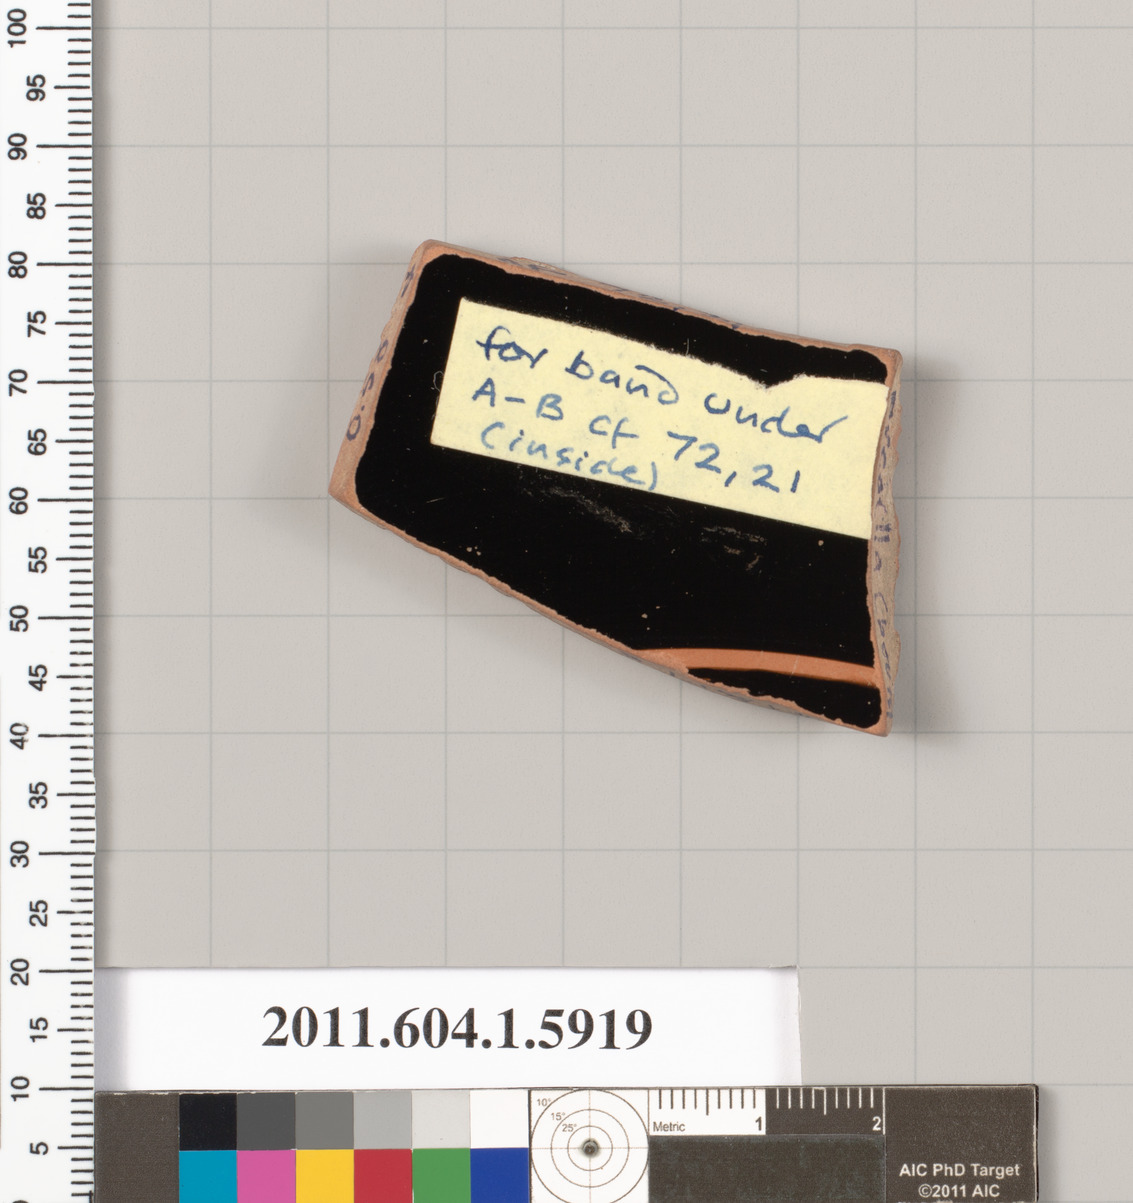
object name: kylix fragment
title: Terracotta fragment of a kylix (drinking cup)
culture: greek, attic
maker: epiktetos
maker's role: artist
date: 520-510 BCE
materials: terracotta